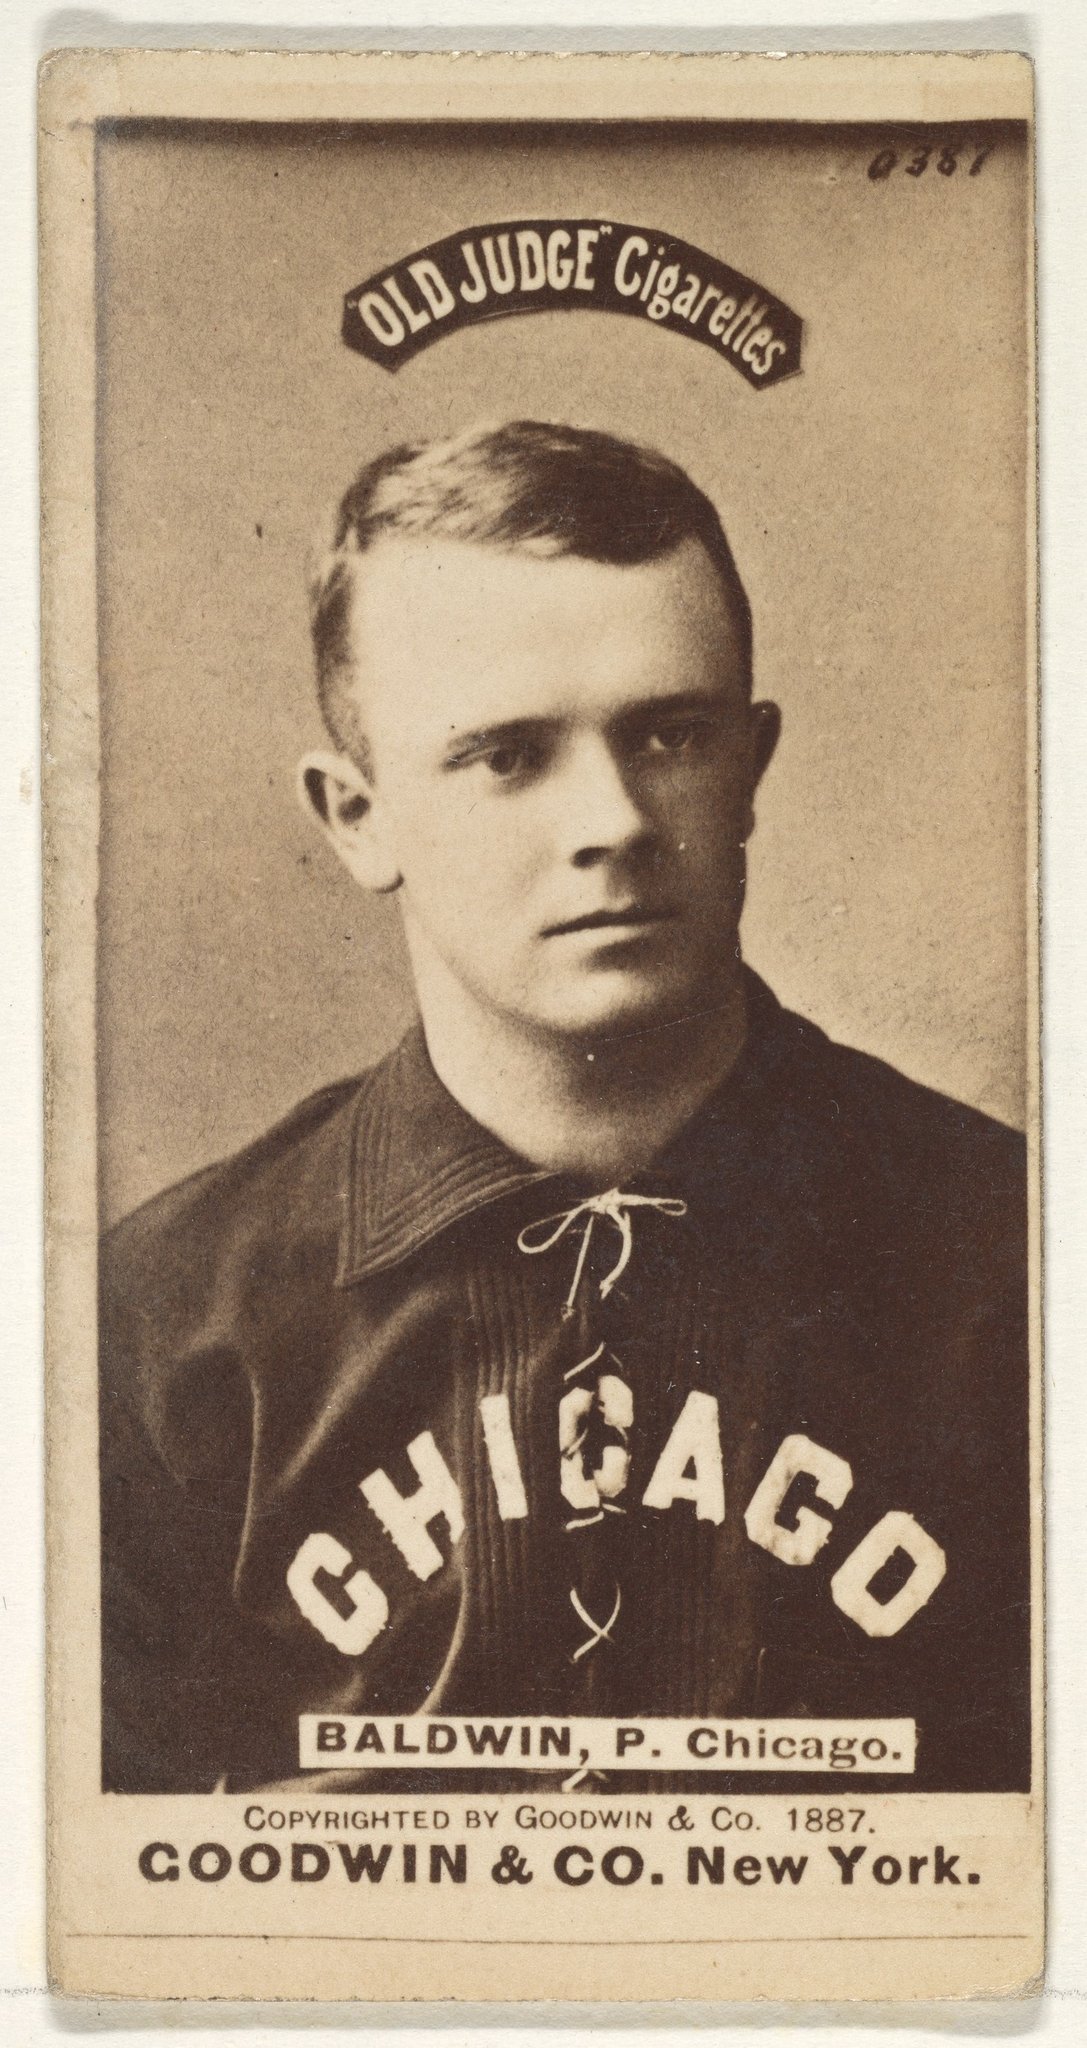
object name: baseball card, photograph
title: Baldwin, Pitcher, Chicago, from the Old Judge series (N172) for Old Judge Cigarettes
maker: goodwin & company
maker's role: publisher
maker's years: 1850-1950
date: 1887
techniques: albumen silver print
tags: men,portraits,baseball,athletes